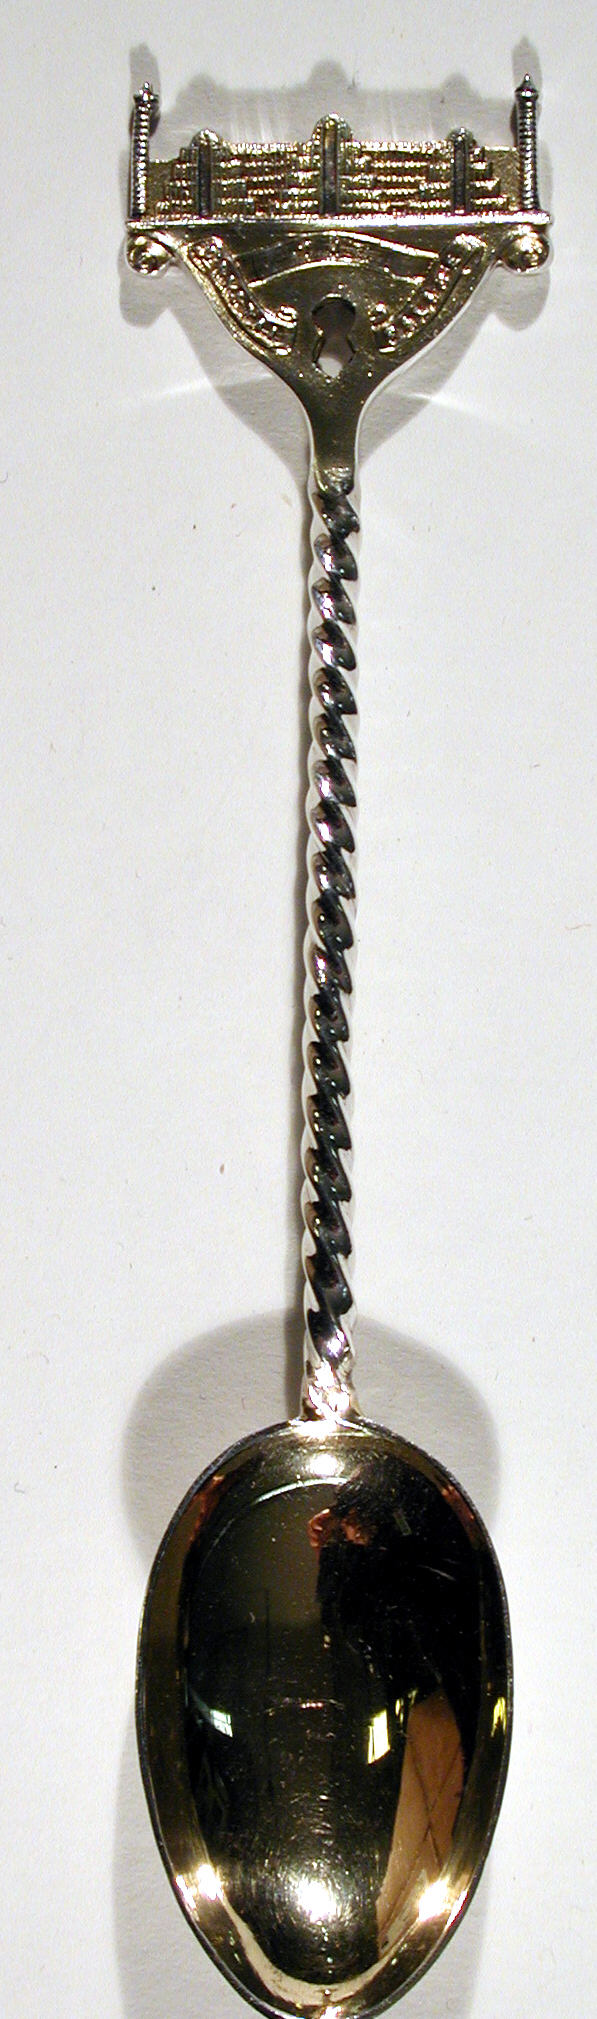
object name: souvenir spoon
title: Souvenir spoon with finial in form of the Crystal Palace, Hyde Park, London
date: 1896-1897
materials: silver gilt